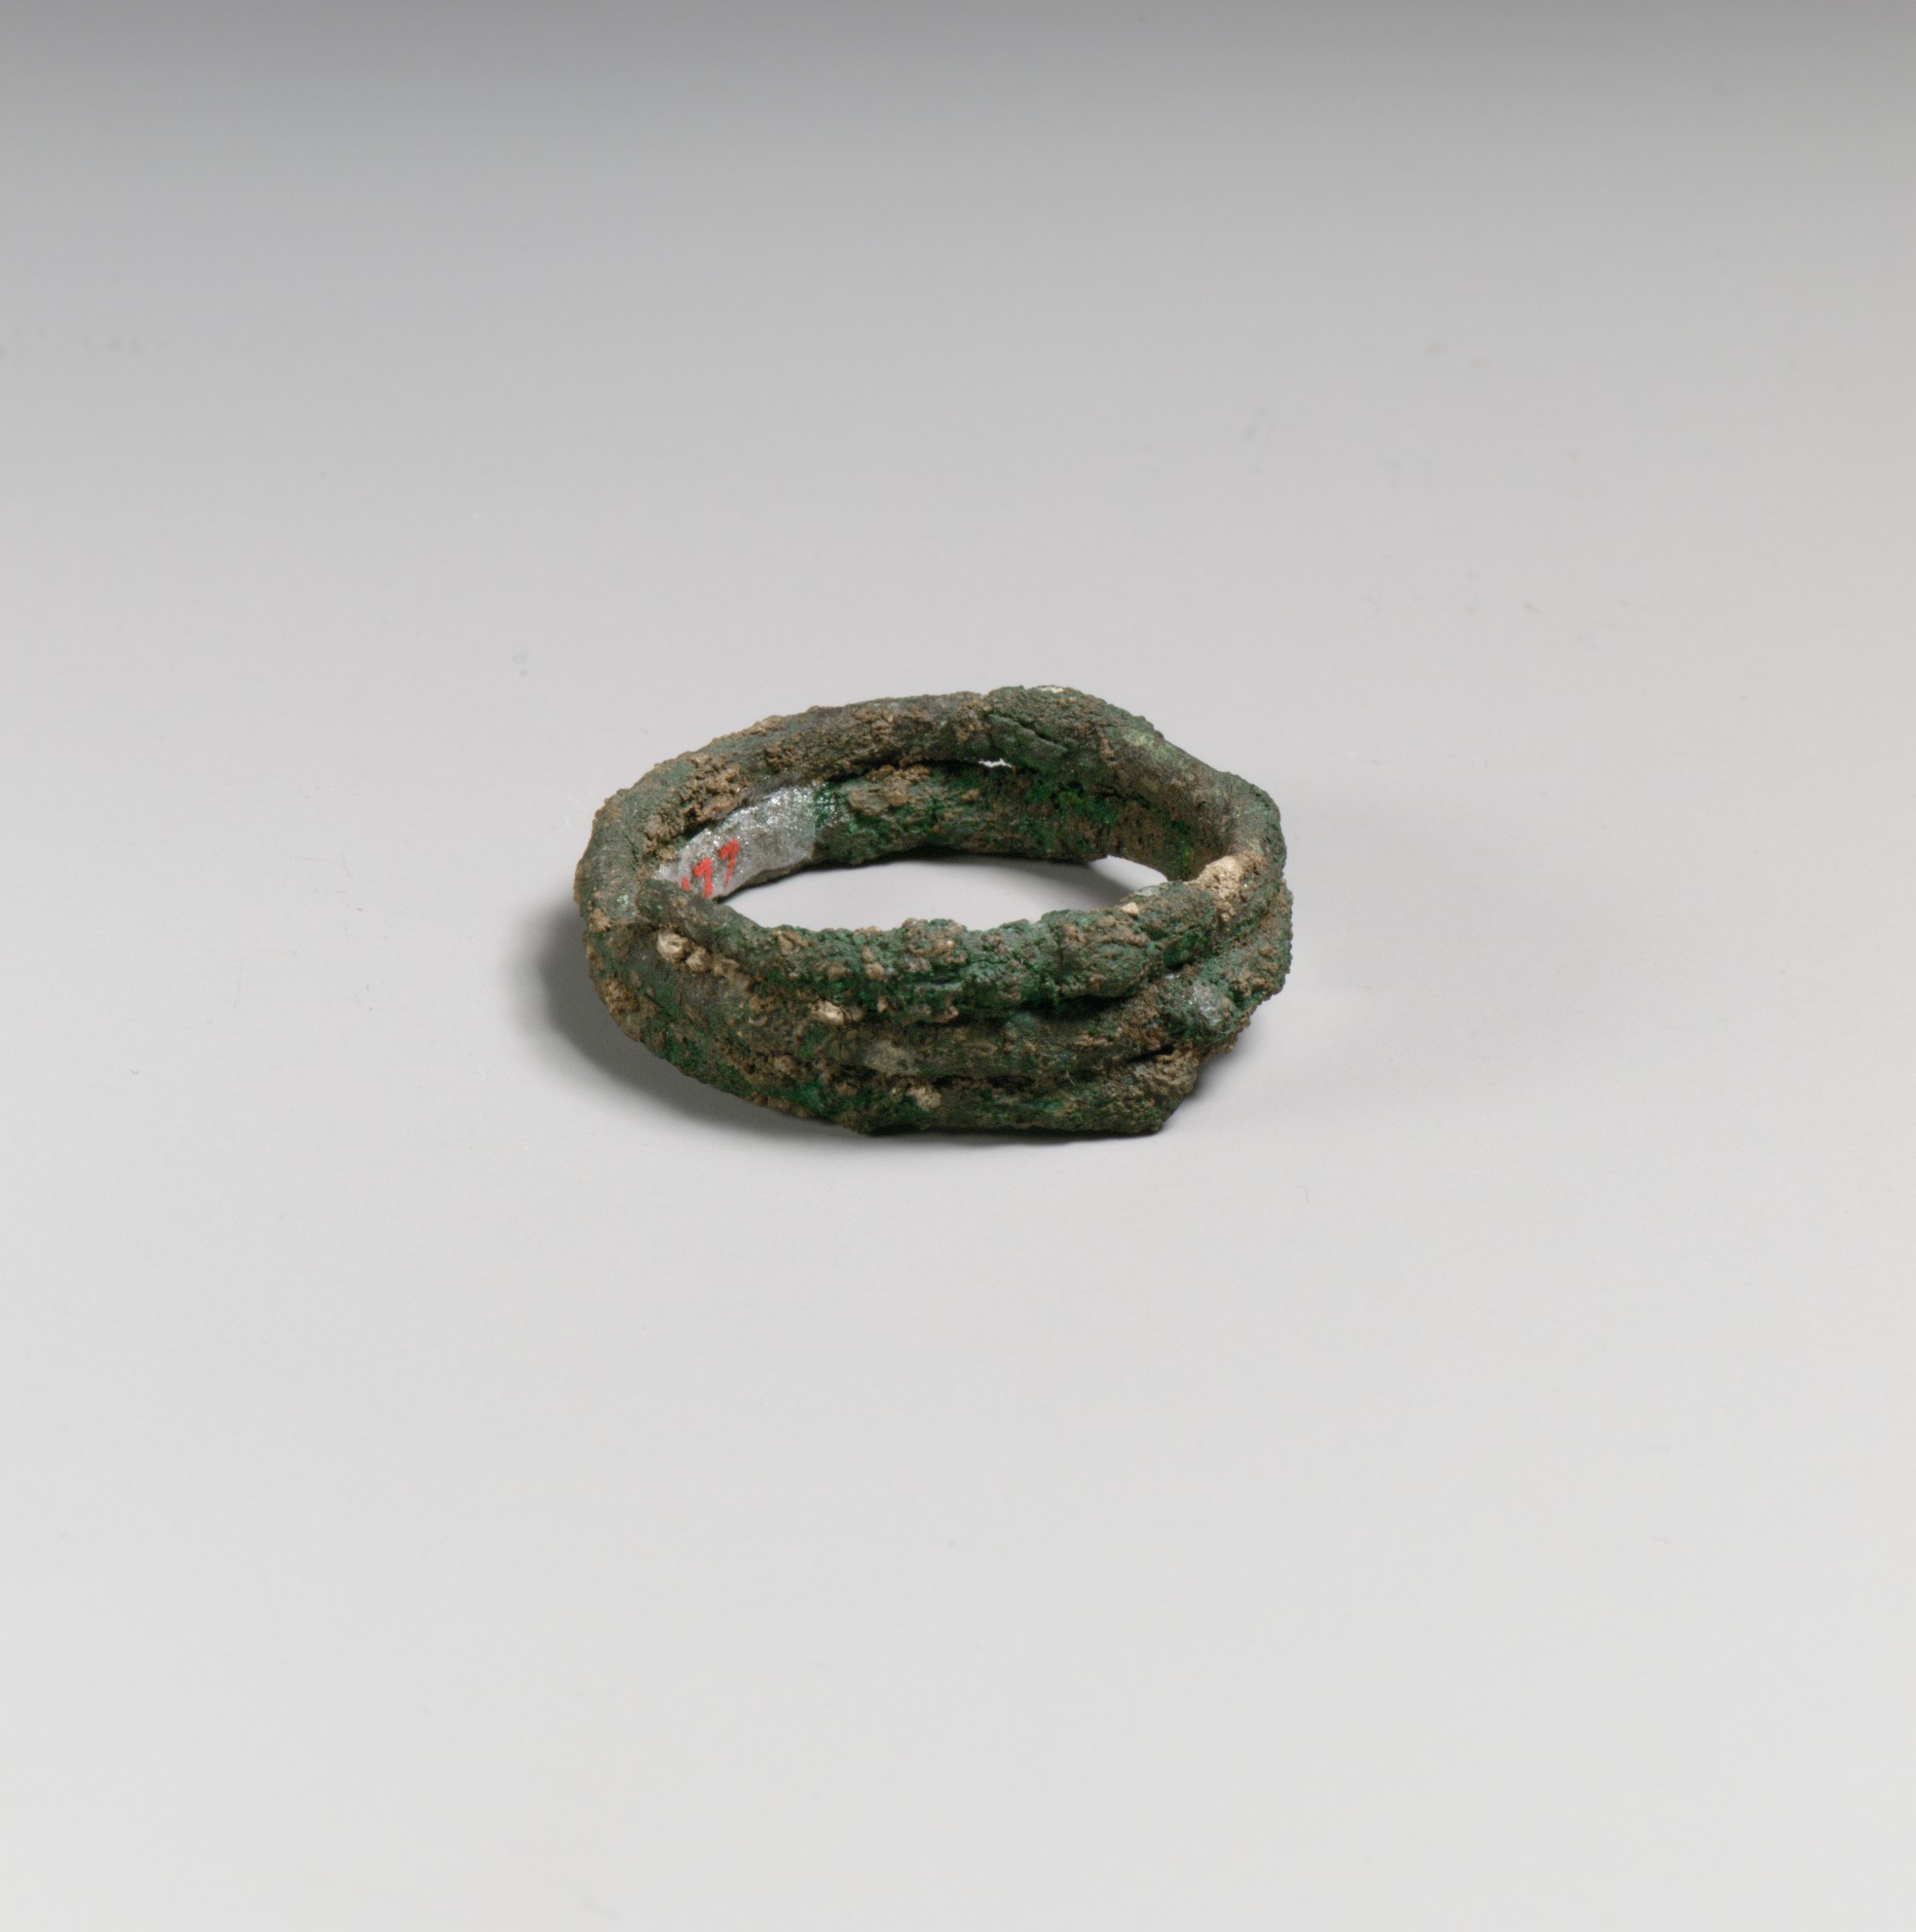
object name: bracelet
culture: cypriot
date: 3900 BCE-100 CE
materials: bronze